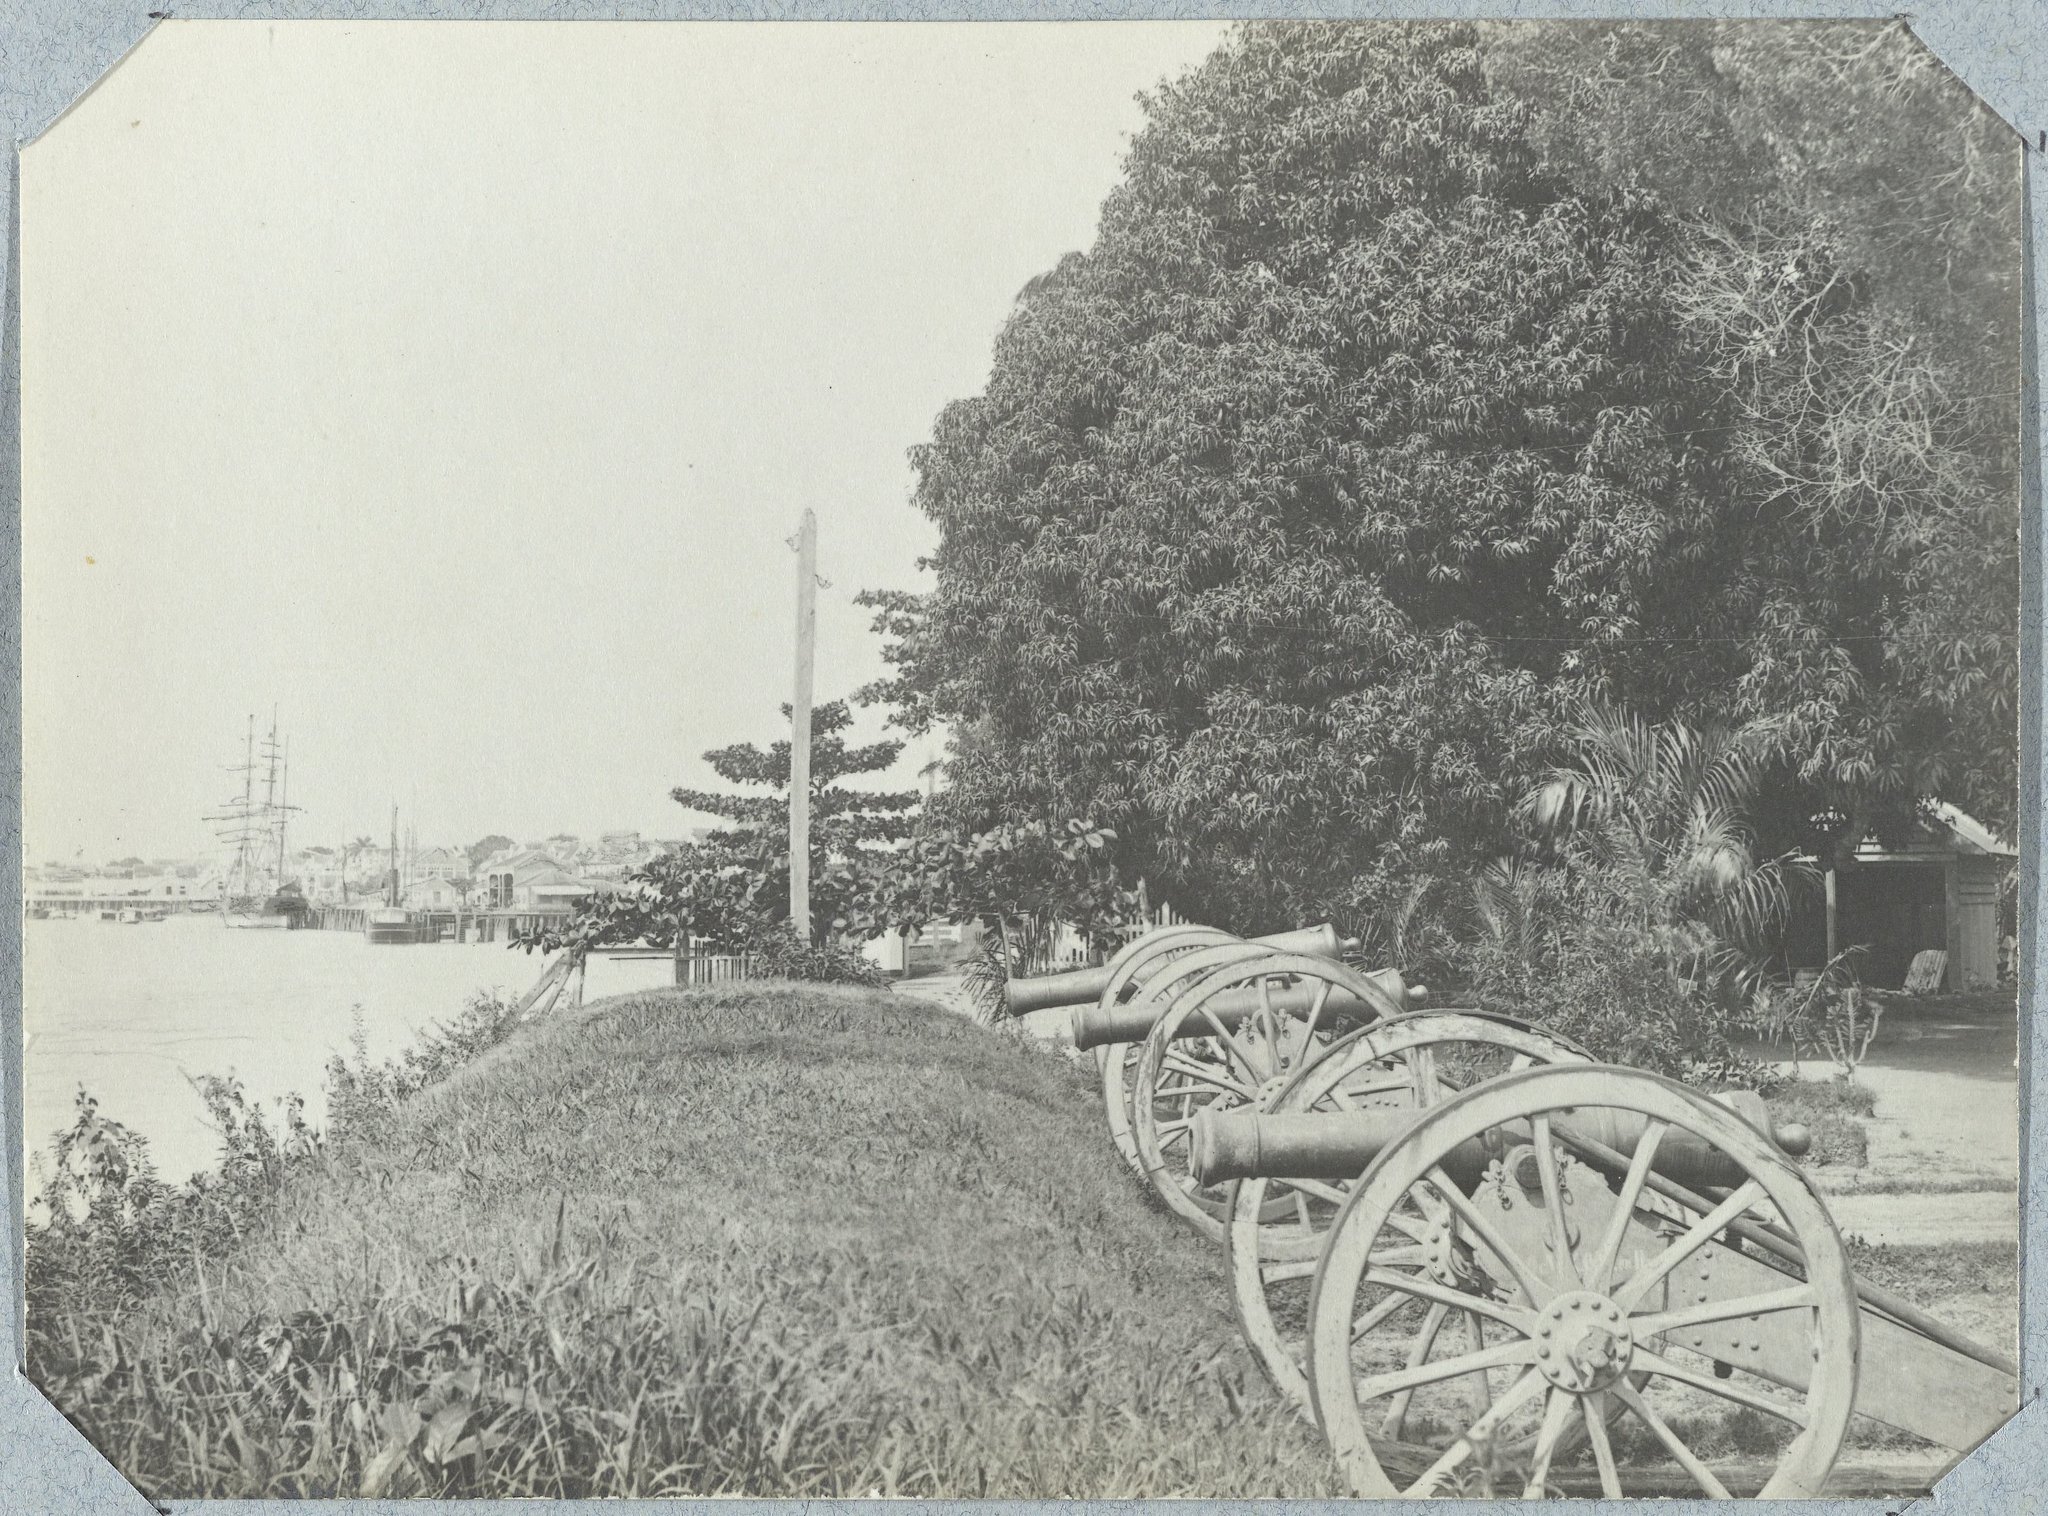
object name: photograph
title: De batterij v/h Fort "Zeelandia"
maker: théodore van lelyveld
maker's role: painter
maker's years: 1867-1954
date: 1896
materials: photographic support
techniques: gelatin silver print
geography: suriname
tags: fortress, firearms: cannon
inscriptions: inscription: ‘De batterij v/h Fort "Zeelandia"’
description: Batterij van drie kanonnen bij Fort Zeelandia te Paramaribo. Fotoafdruk in een fotoalbum van Théodore van Lelyveld over Suriname uit 1895-1898.